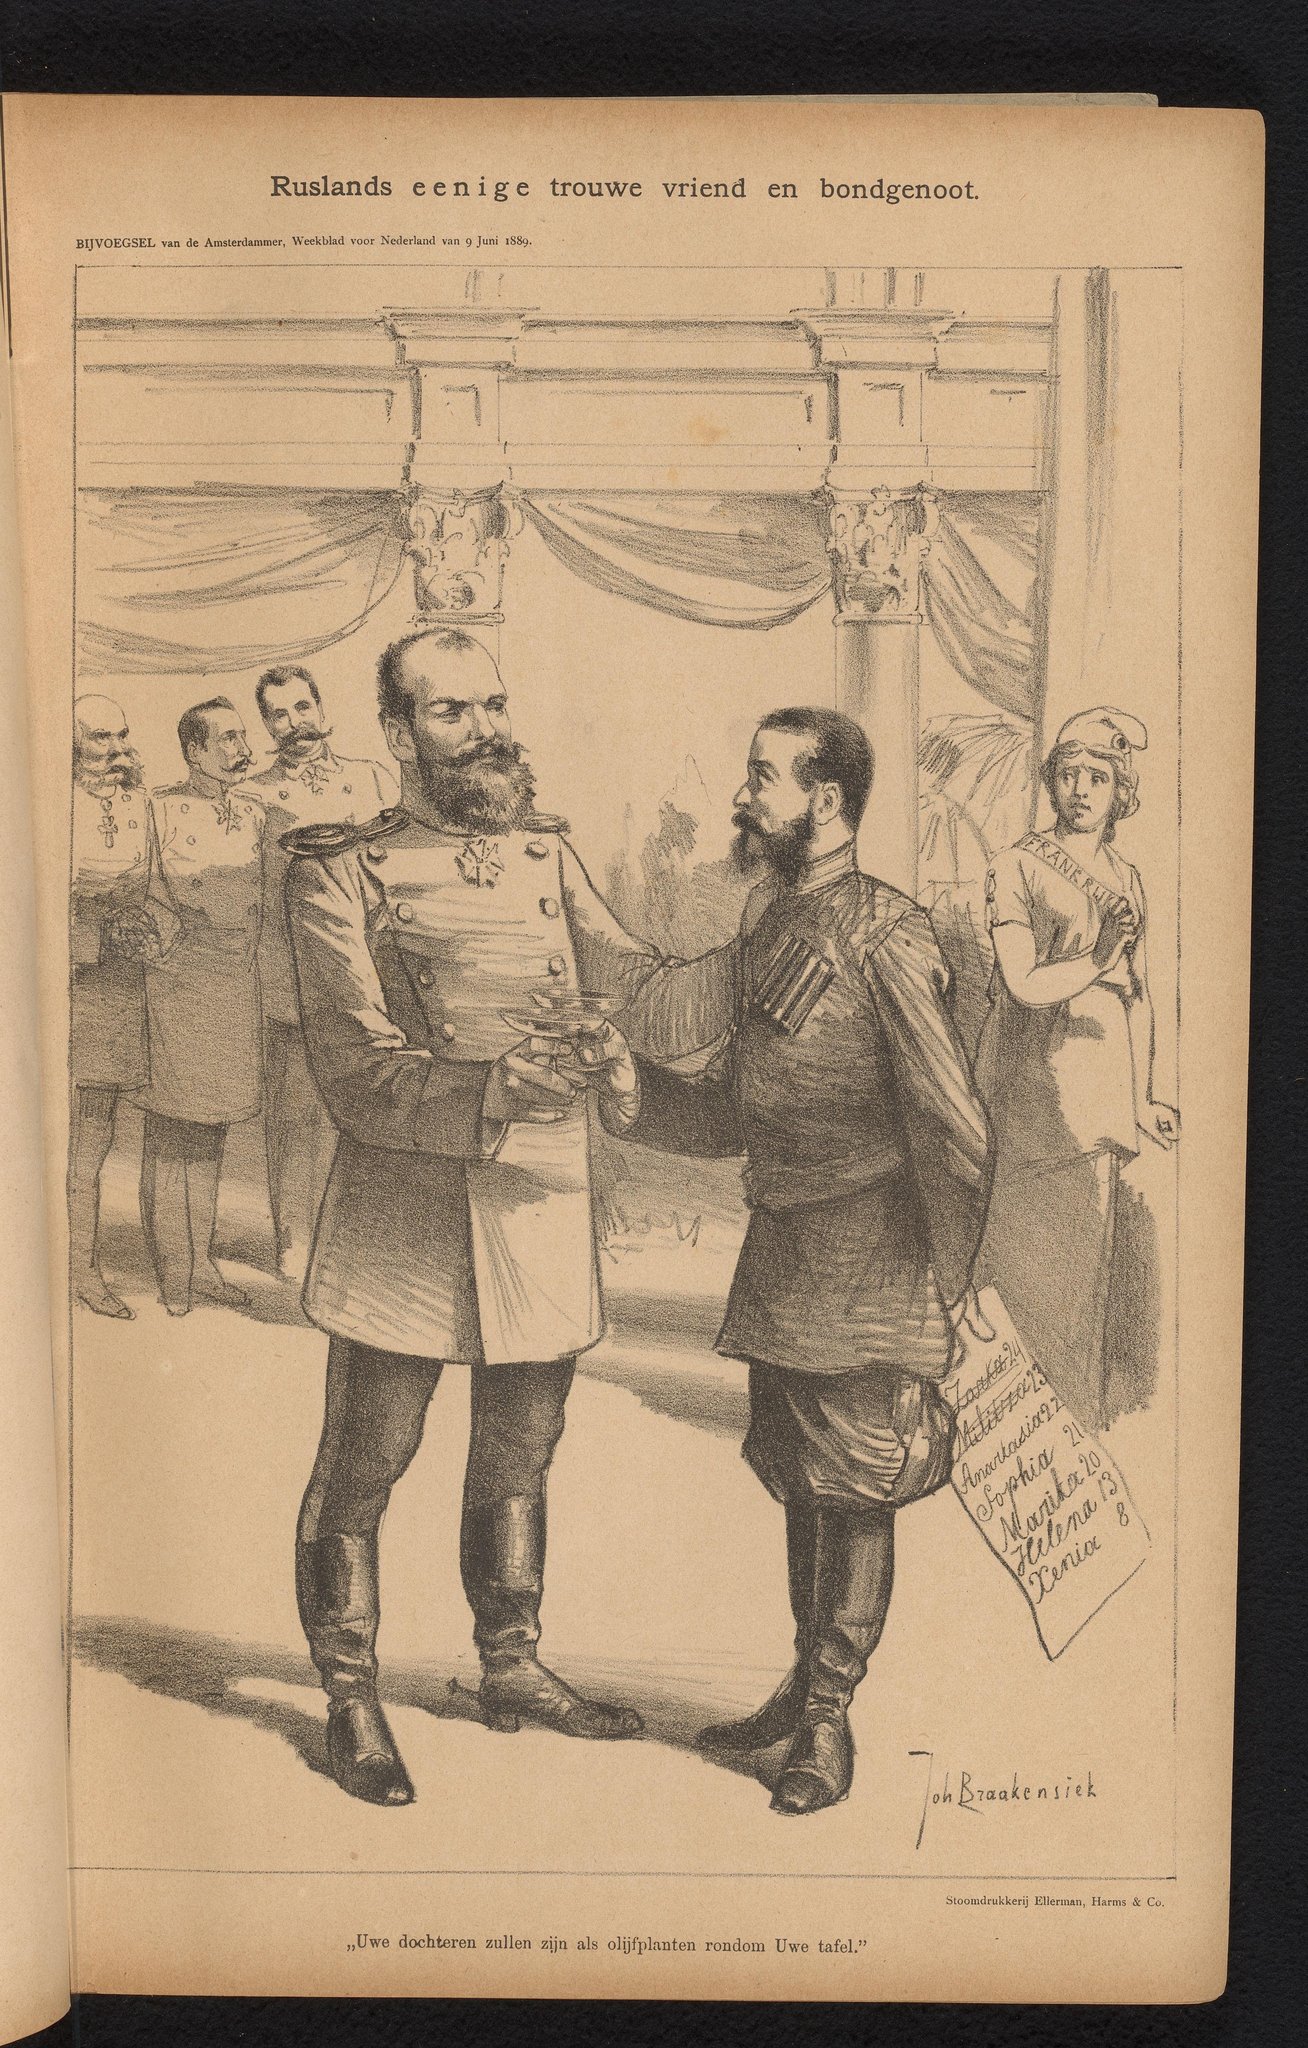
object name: cartoon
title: Ruslands eenige trouwe vriend en bondgenoot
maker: johan braakensiek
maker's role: draughtsman, print maker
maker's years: 1858-1940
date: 1889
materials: paper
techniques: lithograph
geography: netherlands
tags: banquet of elegant company (+ toast at meal, banquet), parental agreement ~ marriage, personifications of countries, nations, states, districts, etc. (+ nation; national), betrothal, political caricatures and satires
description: De Russische tsaar Alexander III heft het glas met vorst Nicolaas I van Montenegro. Vorst Nikita is verheugd dat hij zijn dochters, wiens namen hij op een lijst achter zijn rug houdt, kan uithuwelijken aan Europese vorstenhuizen. Marianne (Frankrijk) kijkt enigszins verschrikt toe. Militza van Montenegro huwde op 26 juli 1889 met grootvorst Peter Nikolajevitsj van Rusland.